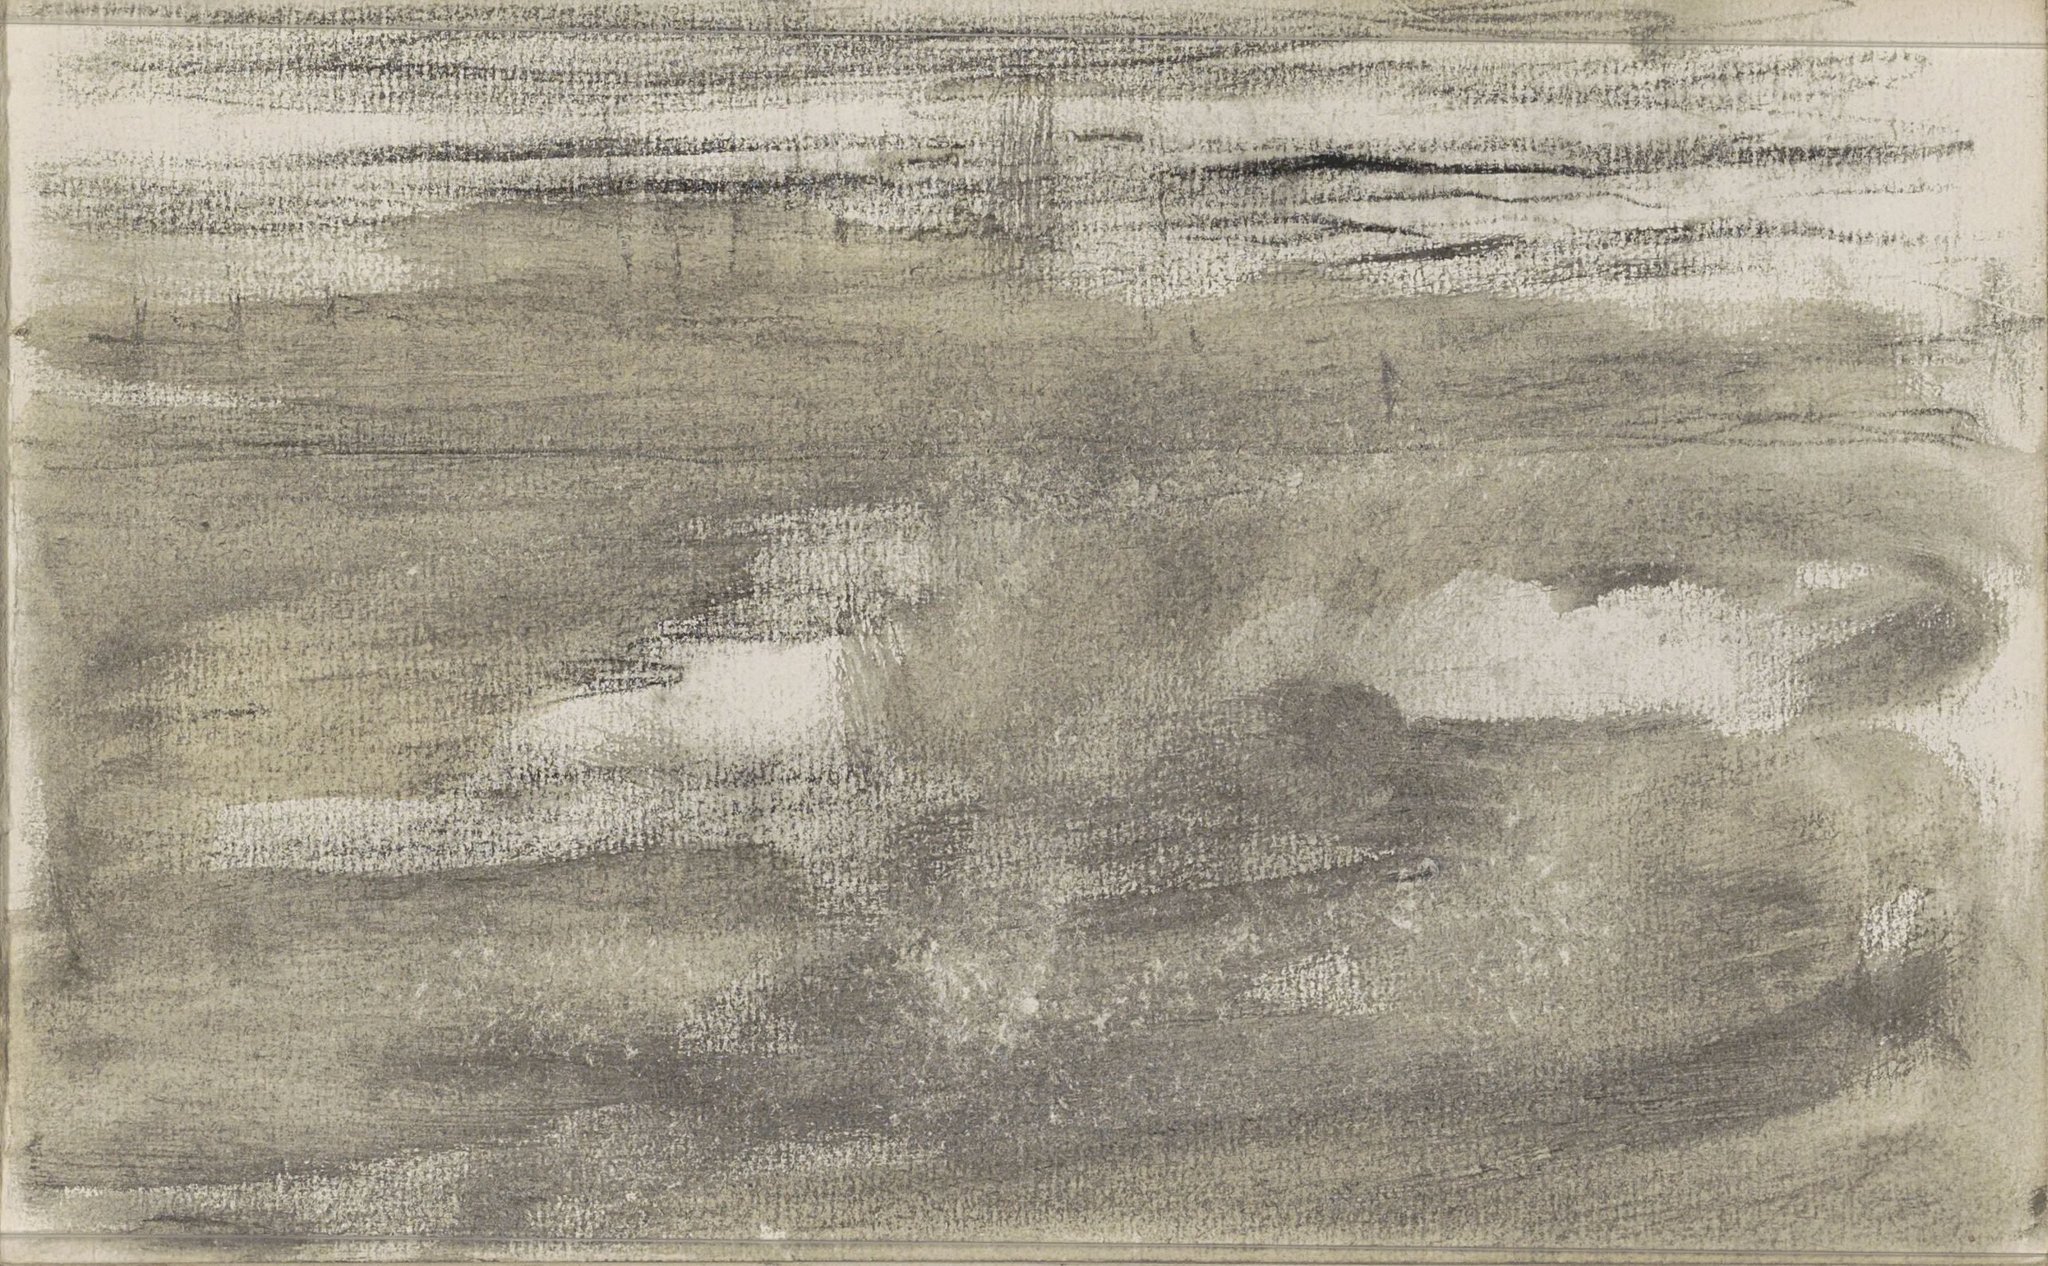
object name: sketchbook leaf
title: Landschap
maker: anton mauve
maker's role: draughtsman, painter, print maker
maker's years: 1838-1888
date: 1848-1888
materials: chalk, paper, watercolor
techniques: brush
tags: landscapes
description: Blad 29 recto uit een schetsboek met 41 bladen.